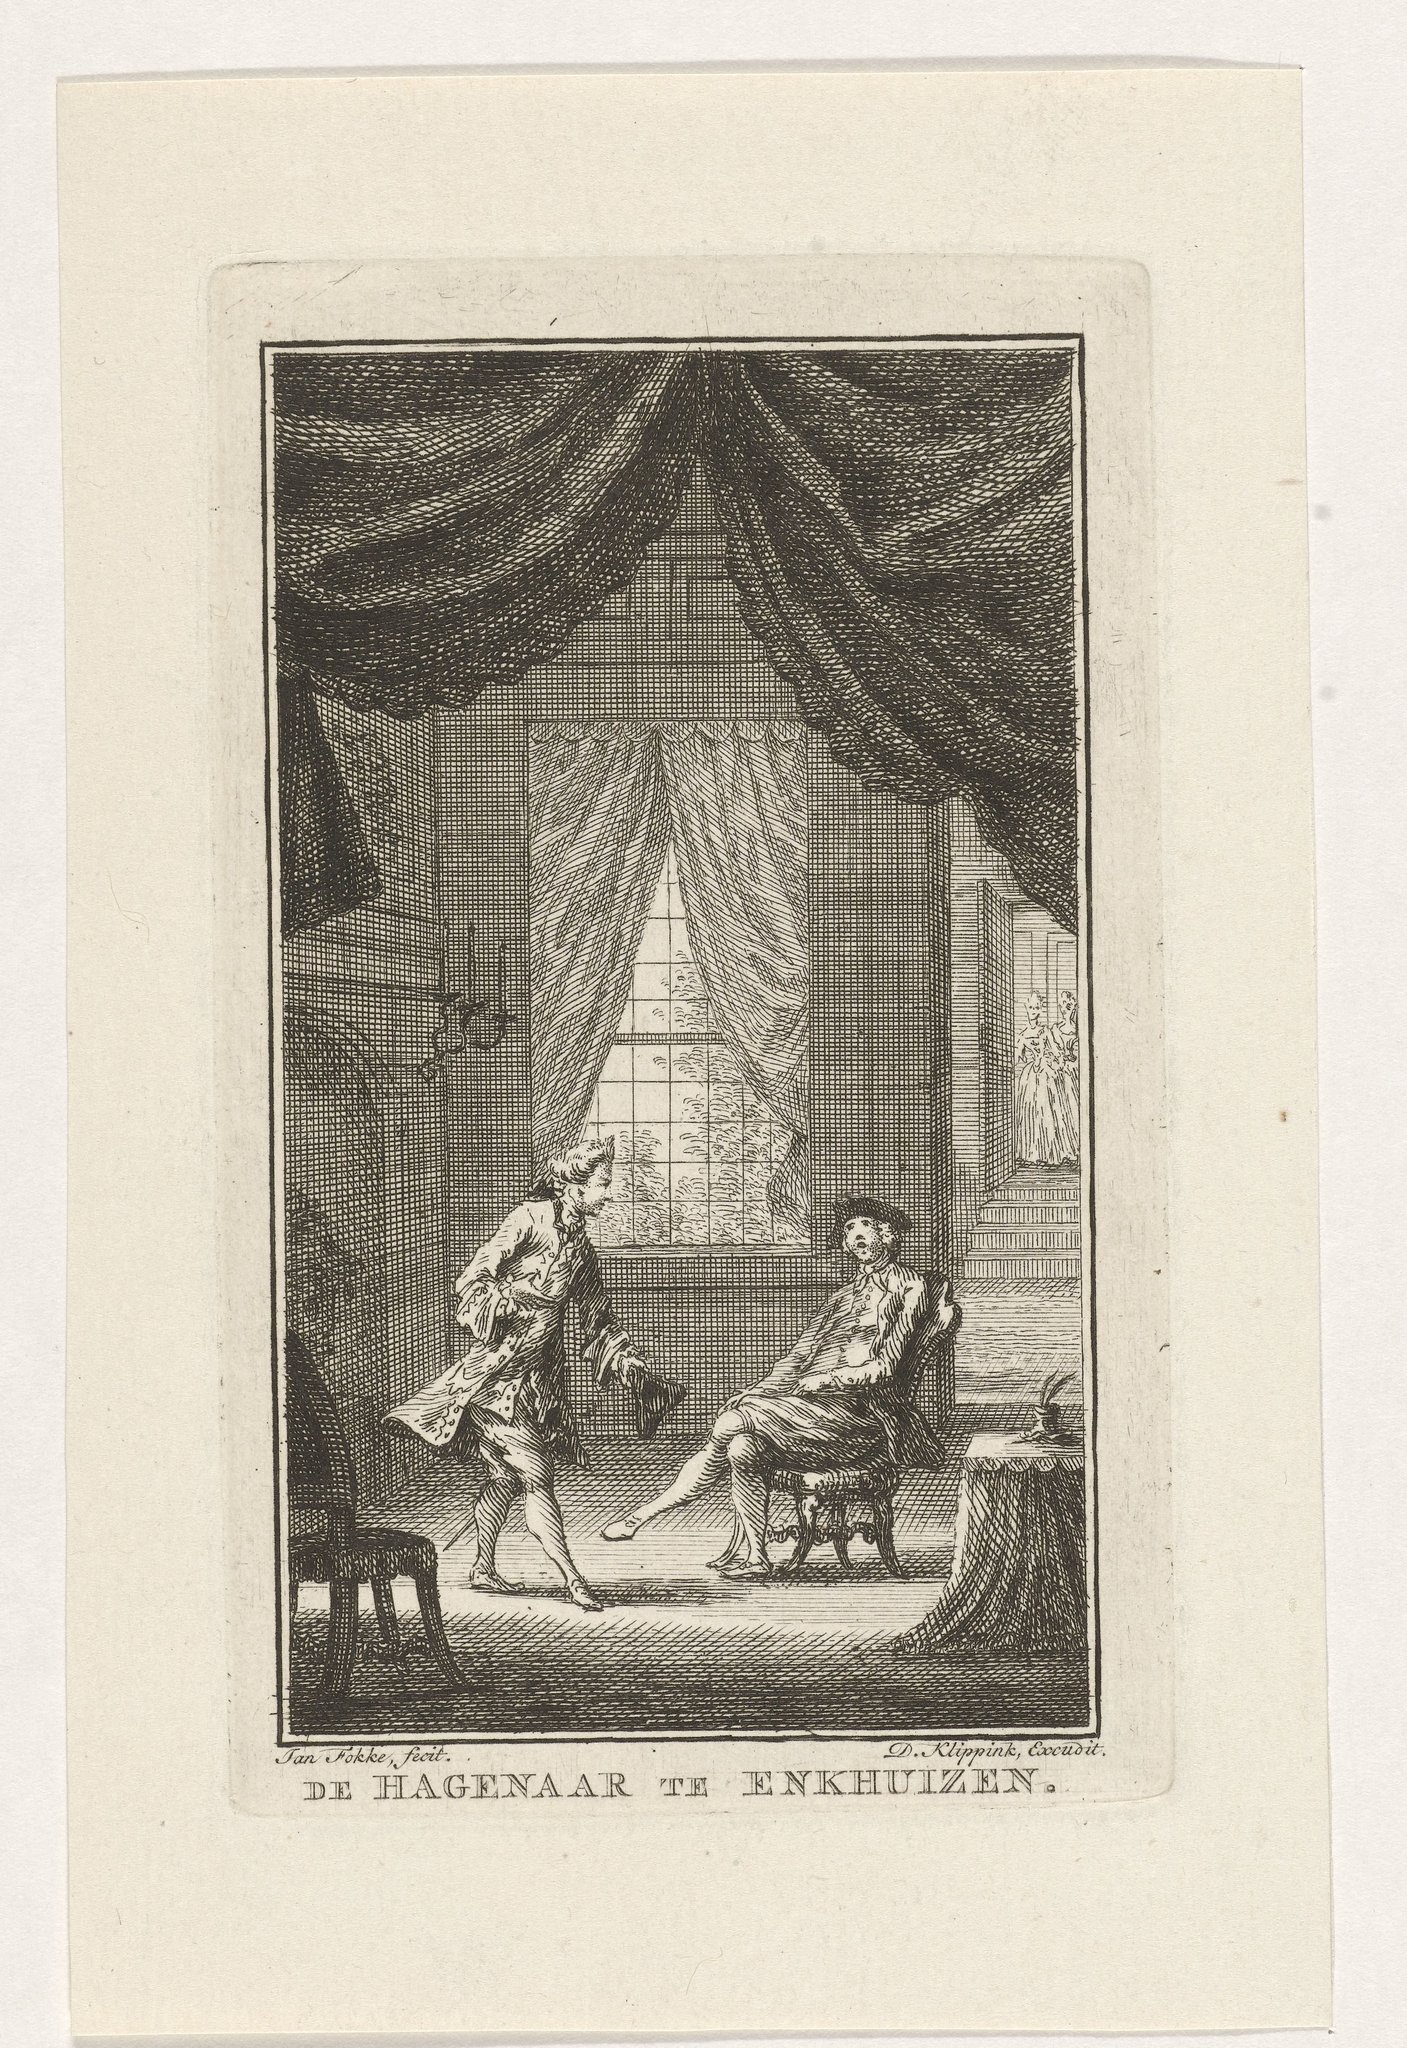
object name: print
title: De Hagenaar te Enkhuizen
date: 1758-1812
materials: paper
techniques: etching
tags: baring the head, lifting one's hat, conversation, dialogue; conversation piece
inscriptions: collector's mark: Lugt 2228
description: Een man zit in een kamer op een stoel en luistert naar de man die met zijn hoed in zijn handen voor hem staat. Deze prent is mogelijk vervaardigd voor het blijspel "De Hagenaar te Enkhuizen" (1758) van Jan Jacob Hartsinck.